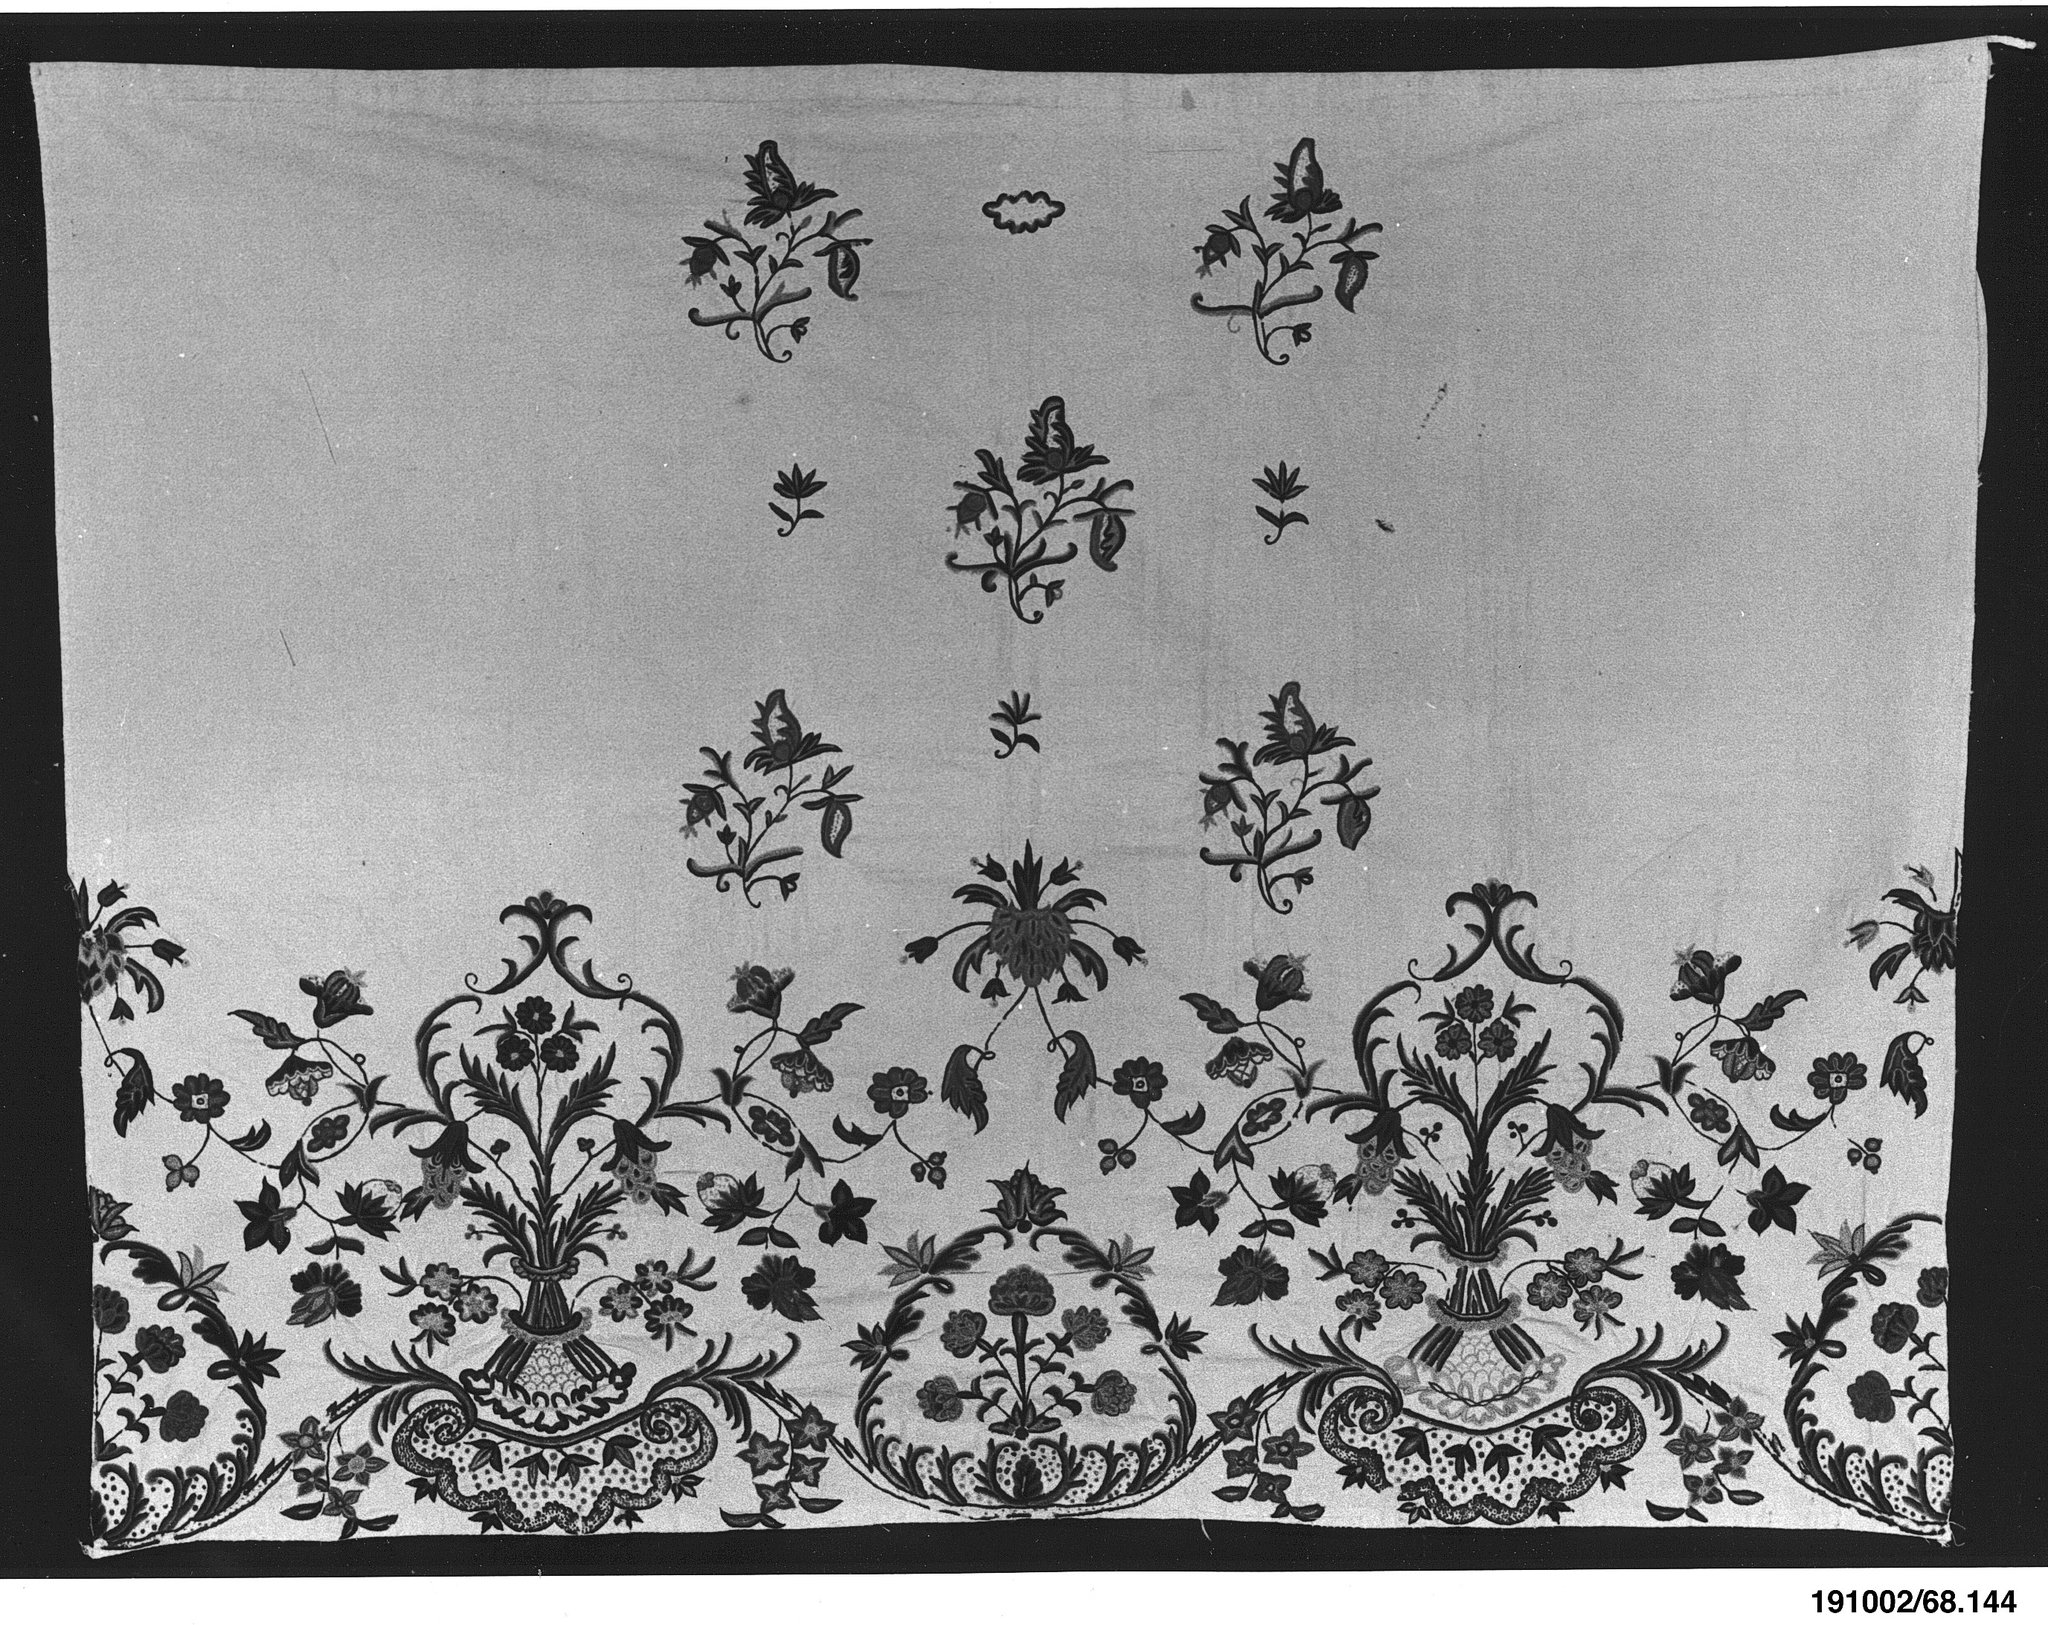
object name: skirt panel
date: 1730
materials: cotton, linen, wool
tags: flowers